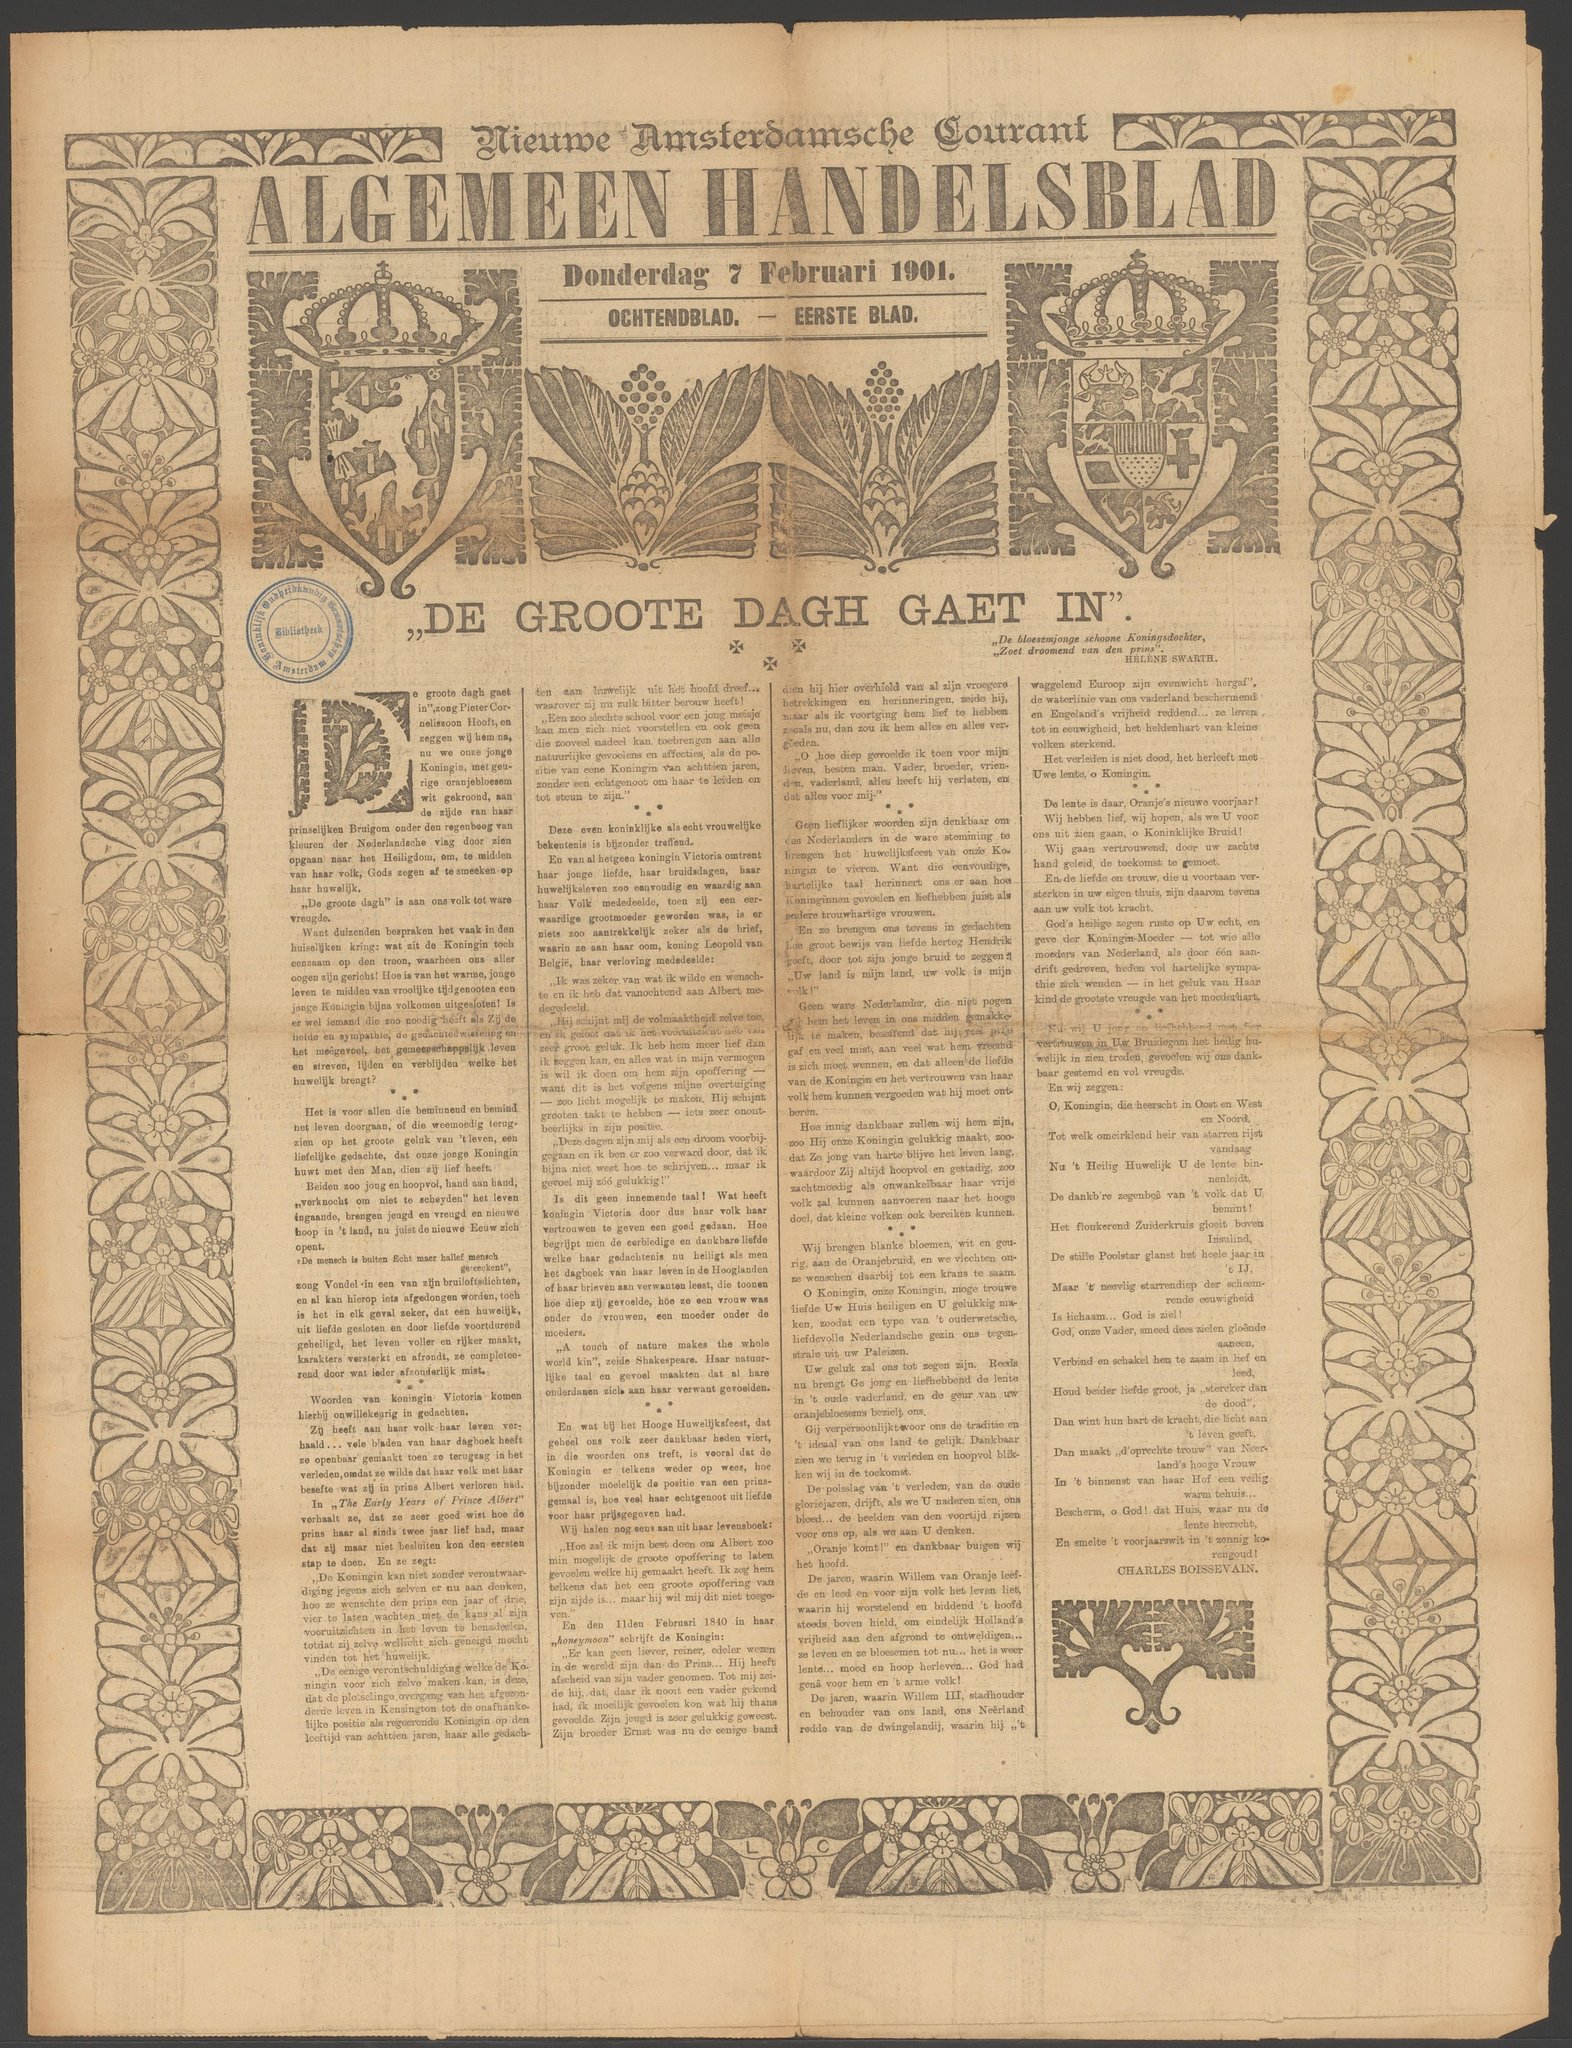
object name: newspaper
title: Algemeen Handelsblad, 7 februari 1901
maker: charles boissevain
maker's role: schrijver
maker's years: 1842-1927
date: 1901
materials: paper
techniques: printing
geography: amsterdam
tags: the hague, print maker, wilhelmina of the netherlands, newspaper, news-sheet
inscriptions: collector's mark: ‘Bibliotheek Koninklijk Oudheidkundig Genootschap Amsterdam’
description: Exemplaar van de Nieuwe Amsterdamsche Courant / Algemeen Handelsblad van 7 februari 1901. Dubbelbladig, op alle zijden bedrukt. Onderwerpsrubrieken binnen de Atlas Zeden en Gewoonten: Regeering, Officieele Nieuwsbladen.